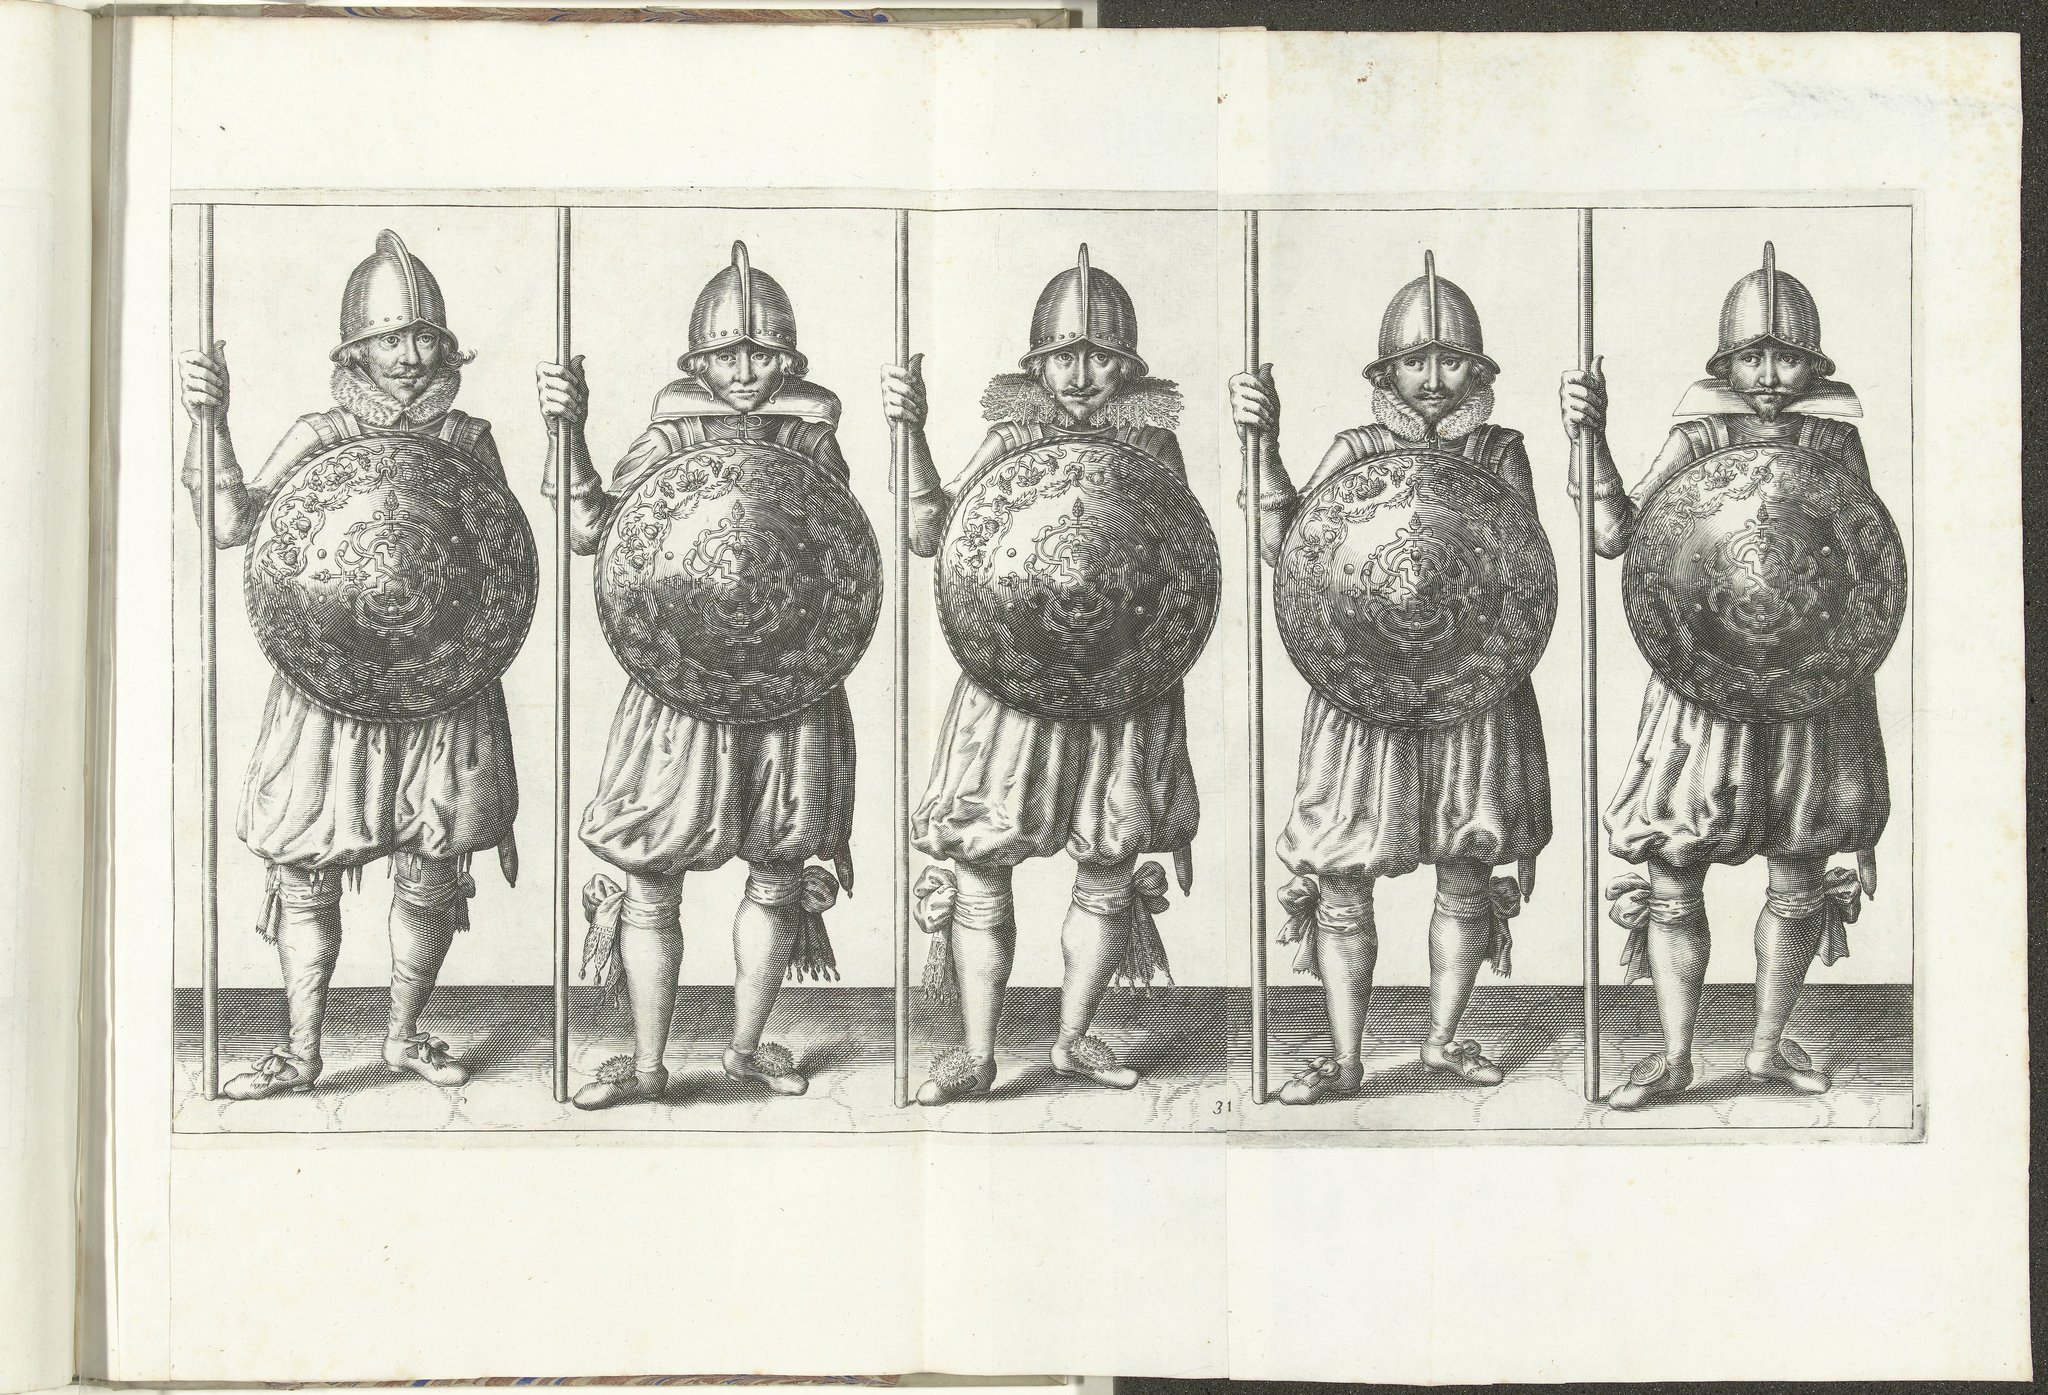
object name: print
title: De exercitie met schild en spies: vijf soldaten staande naast elkaar in het gelid met de spies in de rechterhand rustend op de grond en het schild voor de borst (nr. 31), 1618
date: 1616-1618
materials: paper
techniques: engraving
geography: northern netherlands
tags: maurice (prince of orange), handling of weapons ~ military training, weapons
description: De exercitie met schild en spies: vijf soldaten staande naast elkaar in het gelid met de spies in de rechterhand rustend op de grond en het schild voor de borst, 1618. Grote prent van twee aan elkaar geplakte bladen. Onderdeel van de illustraties in: Adam van Breen, De Nassausche Wapen-Handelinge, 1618, plaat nr. 31. Krijgswezen rond 1600.